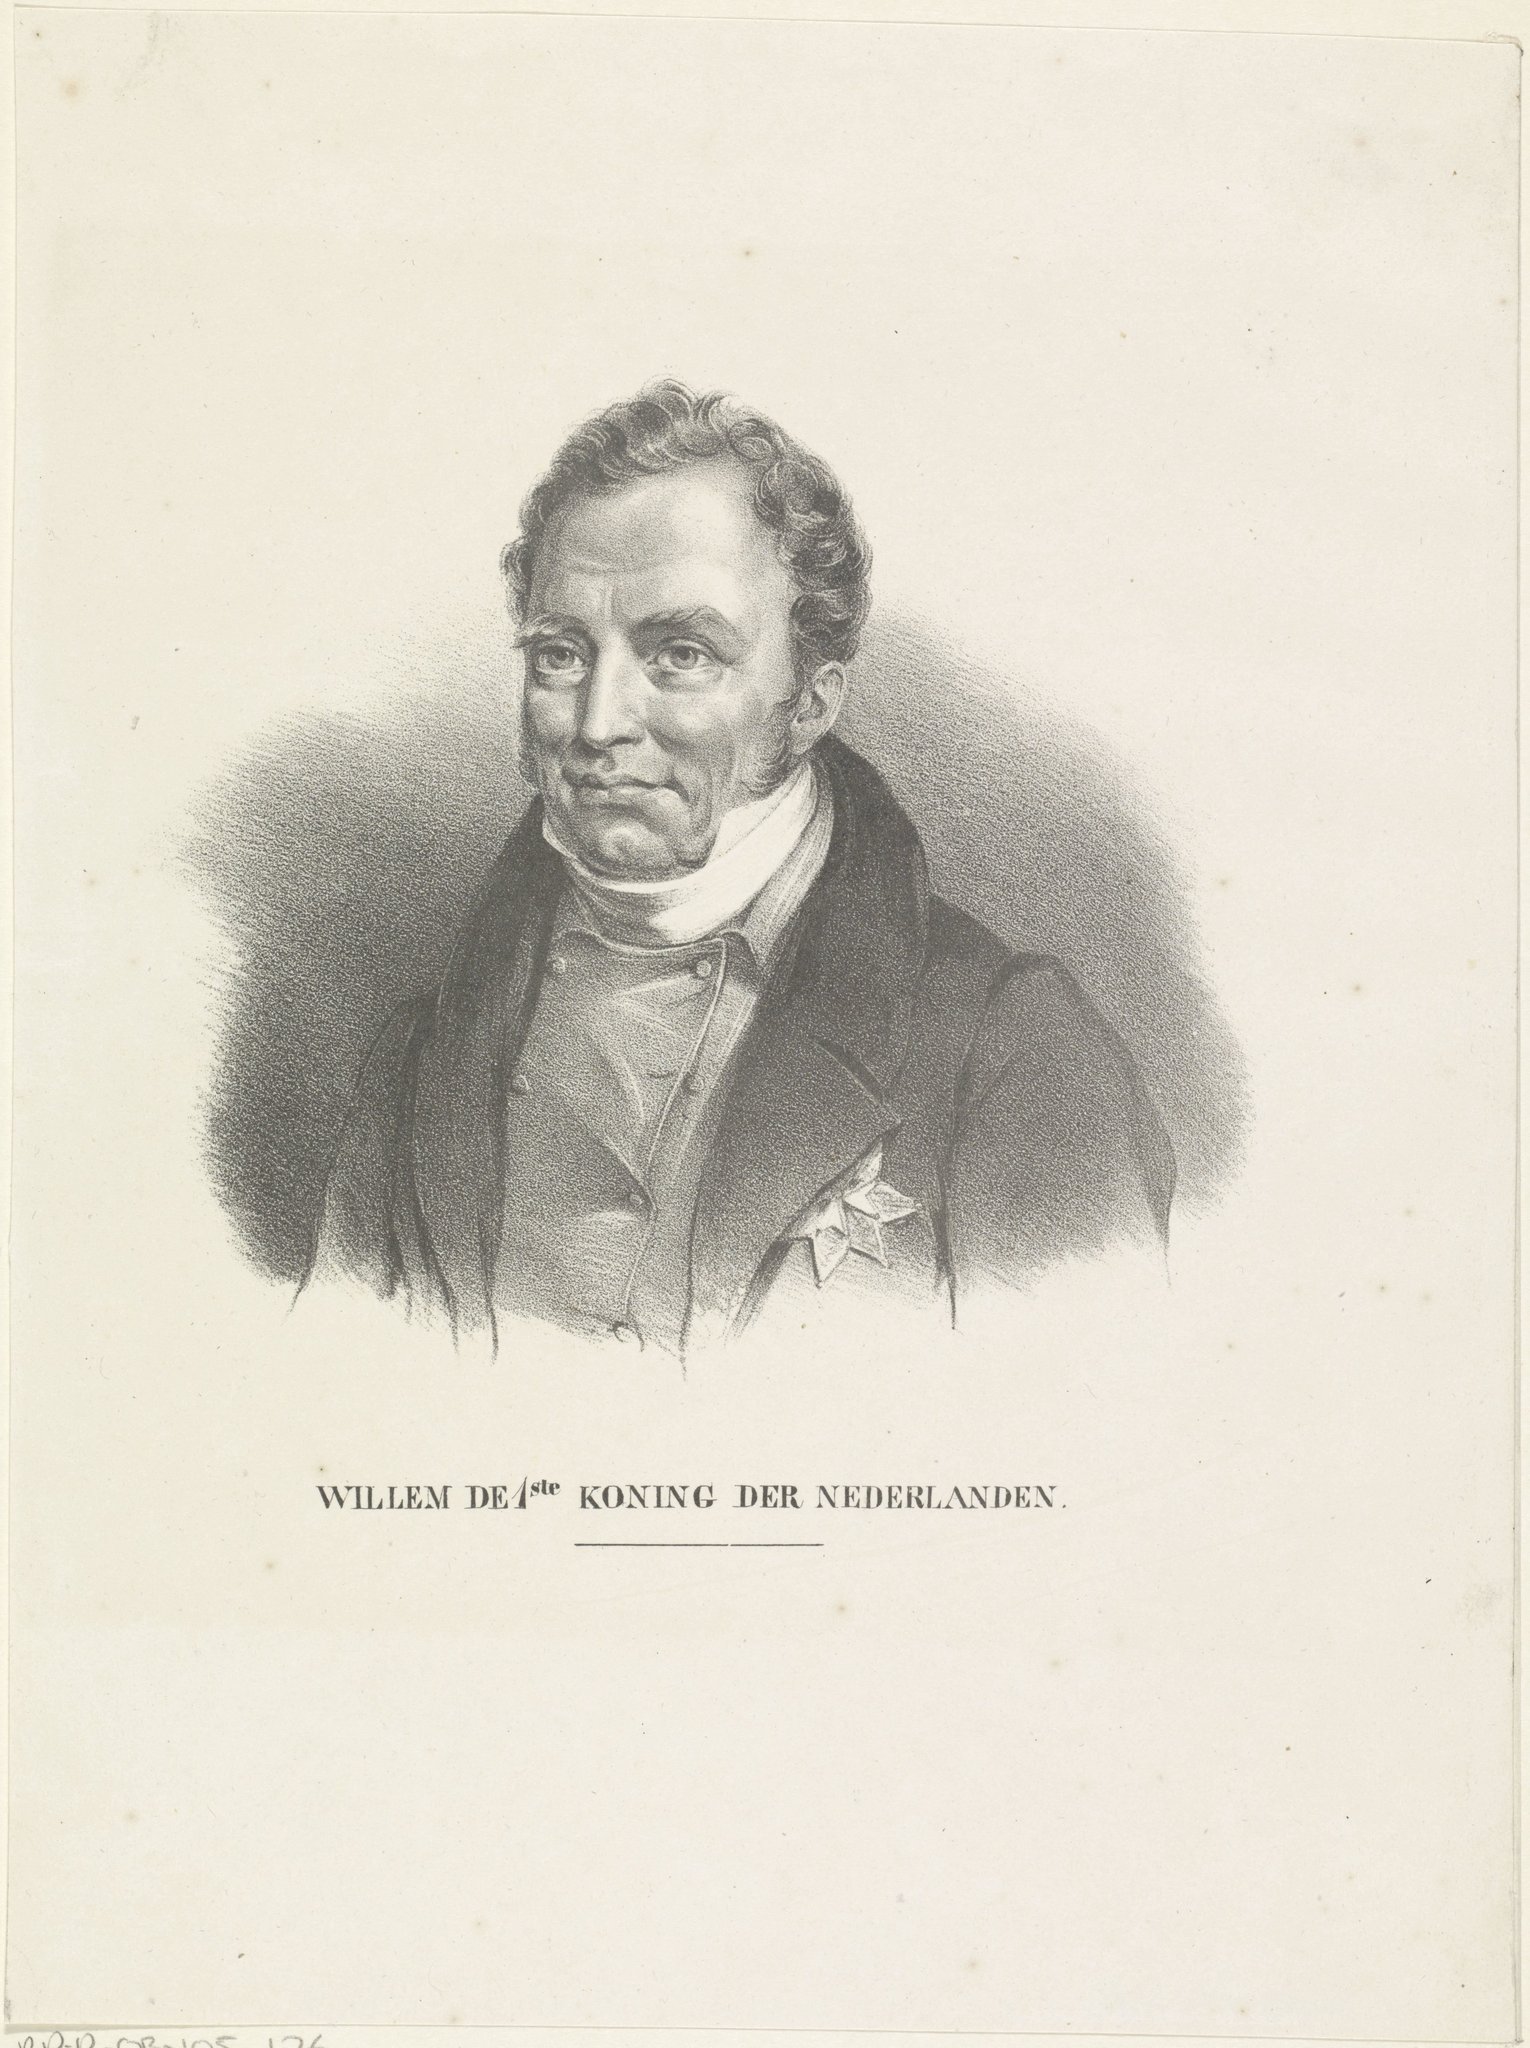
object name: print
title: Portret van Willem I Frederik, koning der Nederlanden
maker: Anonymous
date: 1815-1899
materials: paper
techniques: lithograph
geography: netherlands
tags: the hague, berlin, william i of the netherlands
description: De hier vermelde titel verwijst naar de hoogst verkregen titel van de geportretteerde, niet per se naar de titel die de geportretteerde op deze voorstelling draagt.